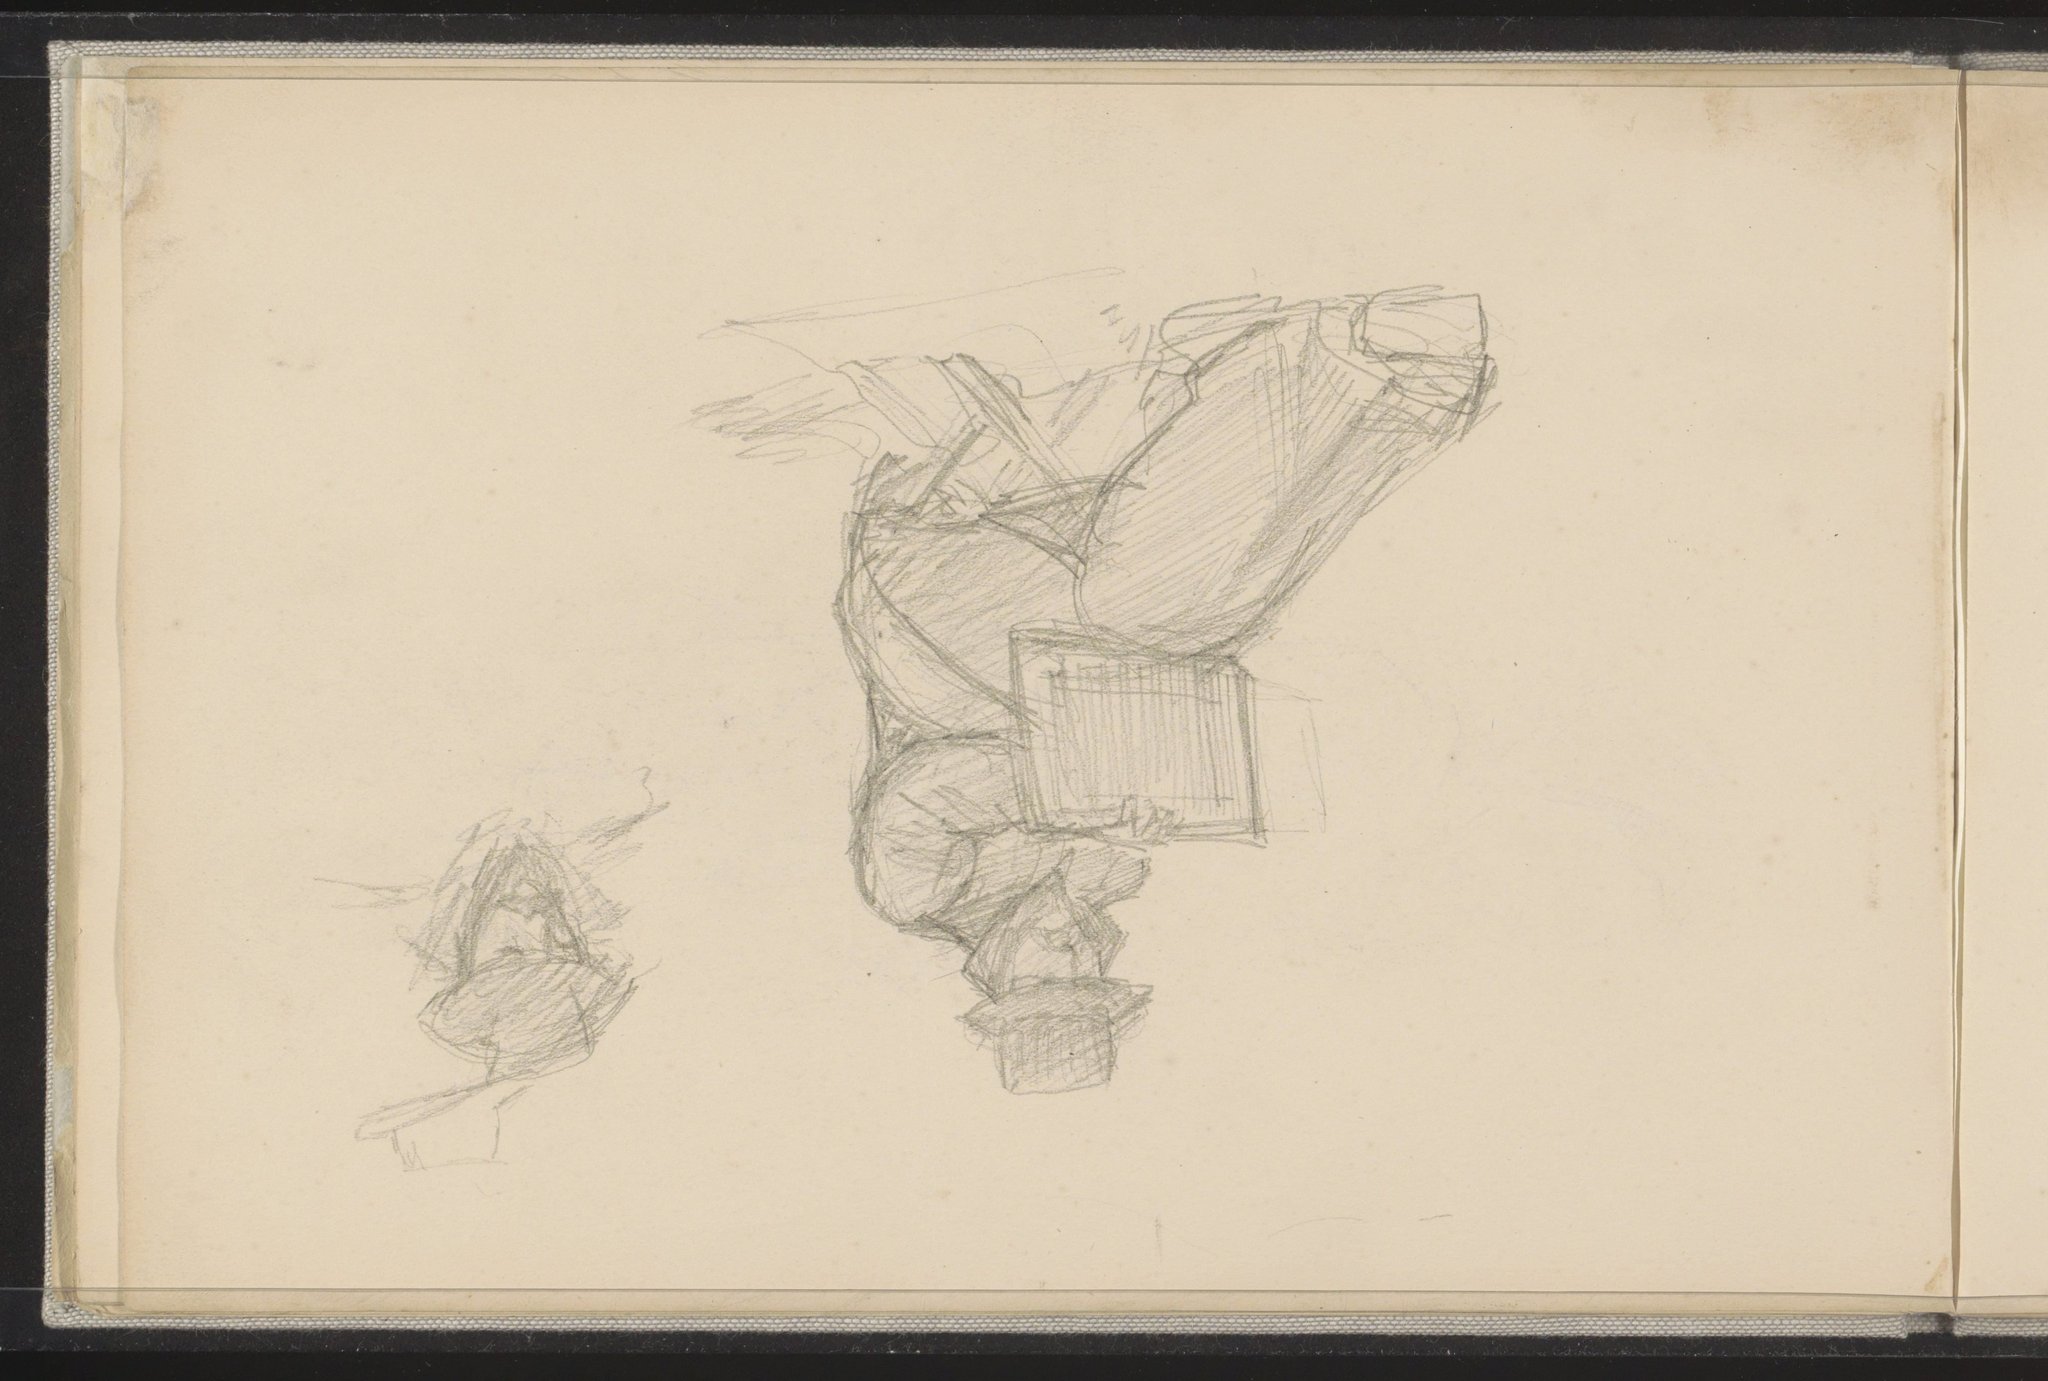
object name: sketchbook leaf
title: Kunstenaar die in de open lucht werkt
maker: jozef israëls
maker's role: draughtsman, painter, print maker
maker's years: 1824-1911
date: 1834-1911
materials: paper, pencil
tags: artist at work, in his workshop - bb - out of doors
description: De kunstenaar zit op een kruk met een deken over zijn benen en heeft een schetsboek voor zich. Tevens een studie van het hoofd met hoed van de man. Blad 11 verso uit een schetsboek met 30 bladen.